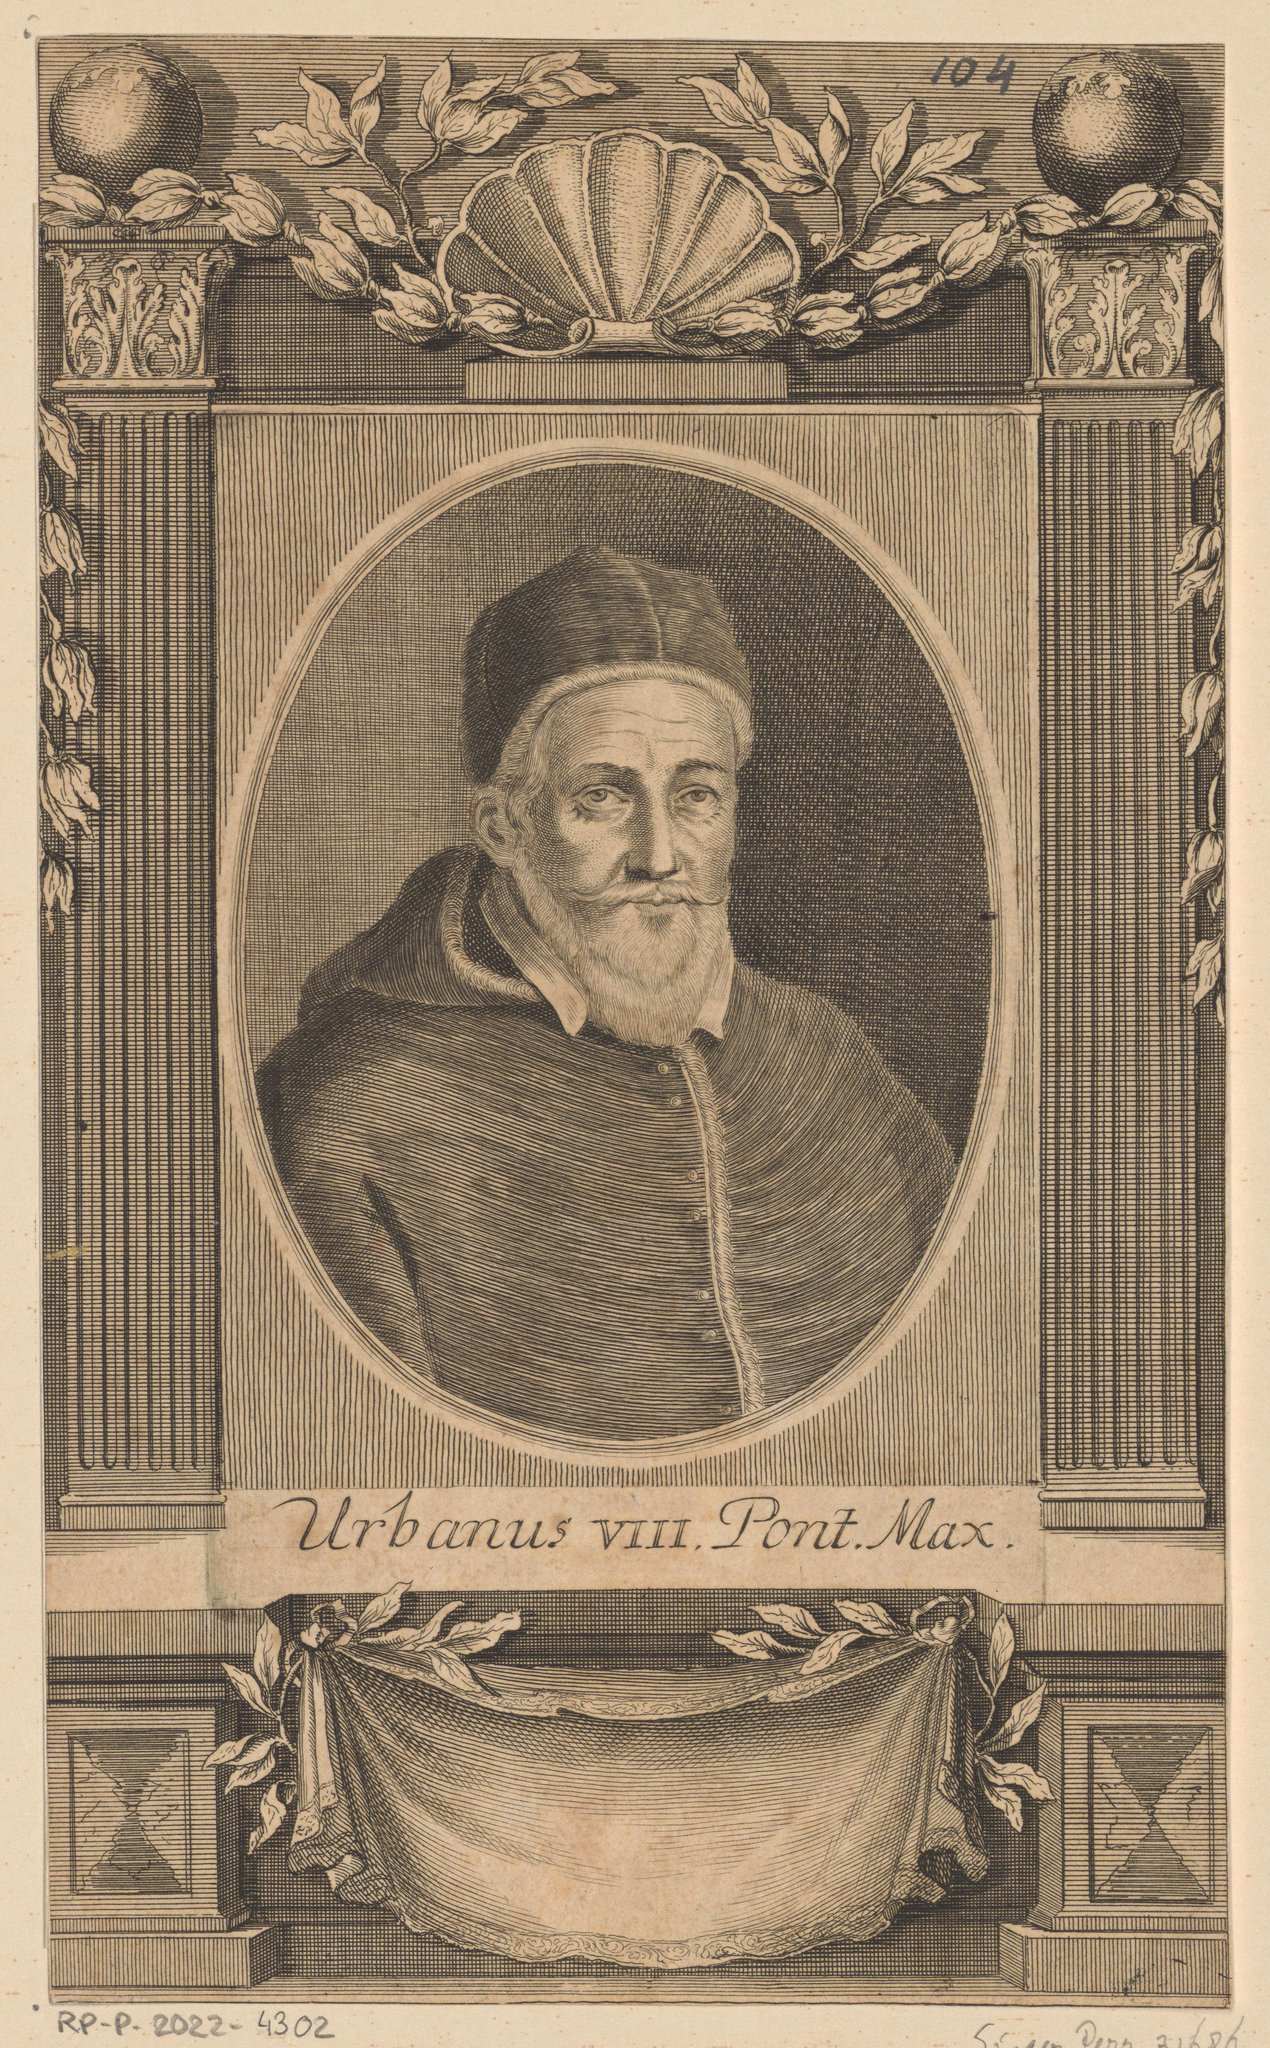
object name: print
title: Portret van paus Urbanus VIII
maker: Anonymous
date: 1721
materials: paper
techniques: engraving, etching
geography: germany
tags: rome, clergyman, urbanus viii, historical persons, pope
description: Prent met een andere omlijsting in: Khevenhüller, Franz Christoph. Conterfet Kupferstich (...). Leipzig: Moritz Georg Weidmann, 1721, dl. 1.